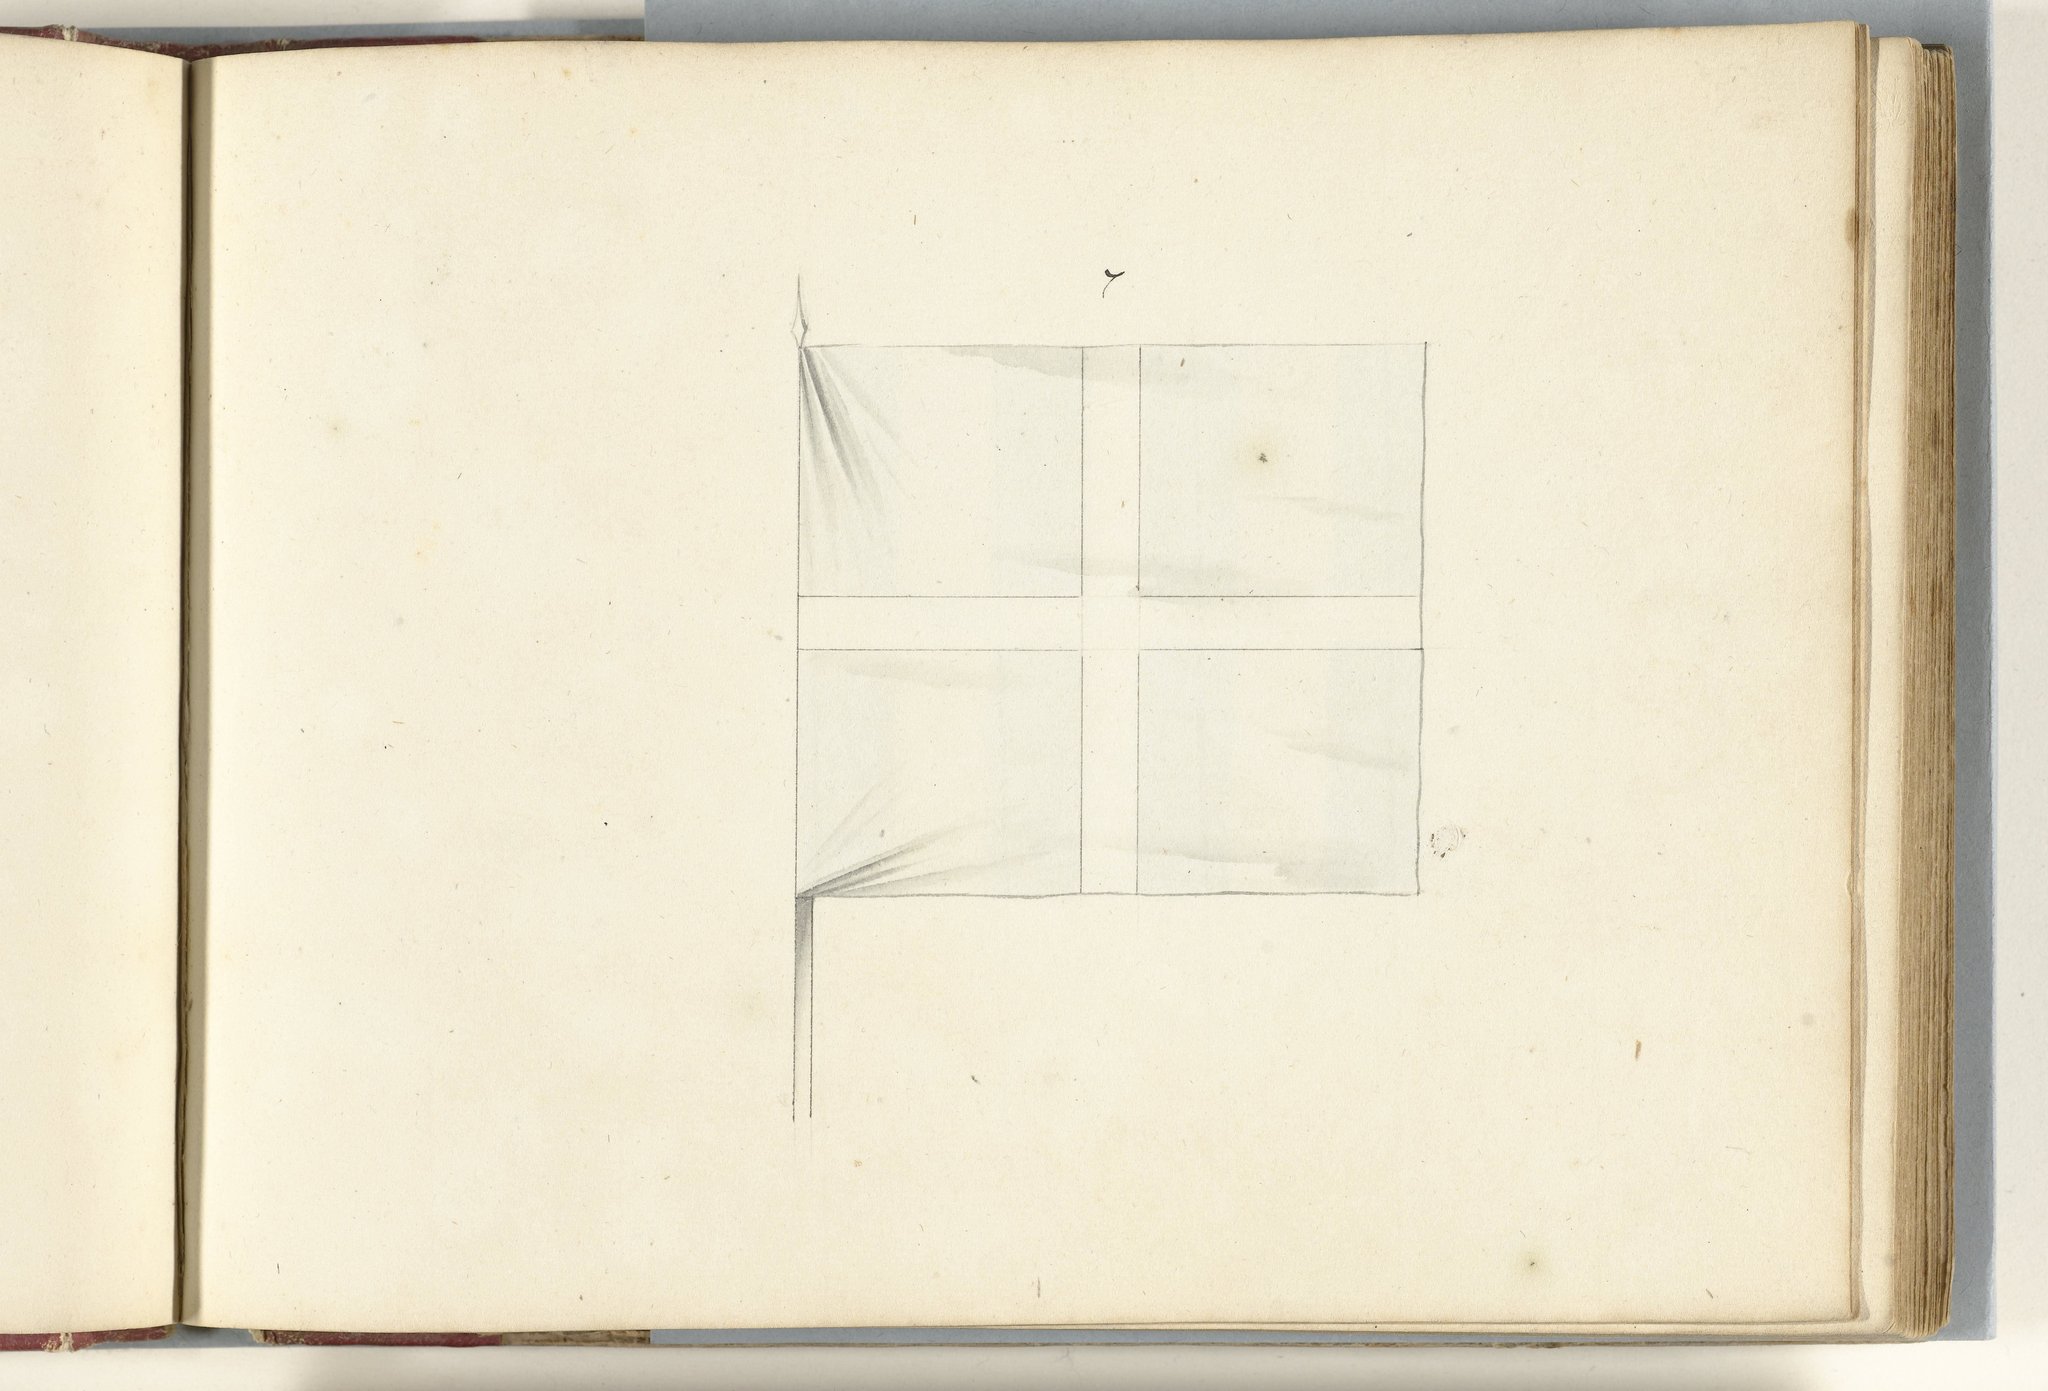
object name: drawing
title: Frans vaandel veroverd bij Dendermonde, 1706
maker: Anonymous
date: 1713-1720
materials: paper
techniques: drawing, writing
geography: northern netherlands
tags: (military) flags and standards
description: Frans vaandel veroverd bij Dendermonde in 1706. In het boek met tekeningen van Franse vaandels, standaarden en pauken, veroverd tijdens de Spaanse Successieoorlog (1701-1713).